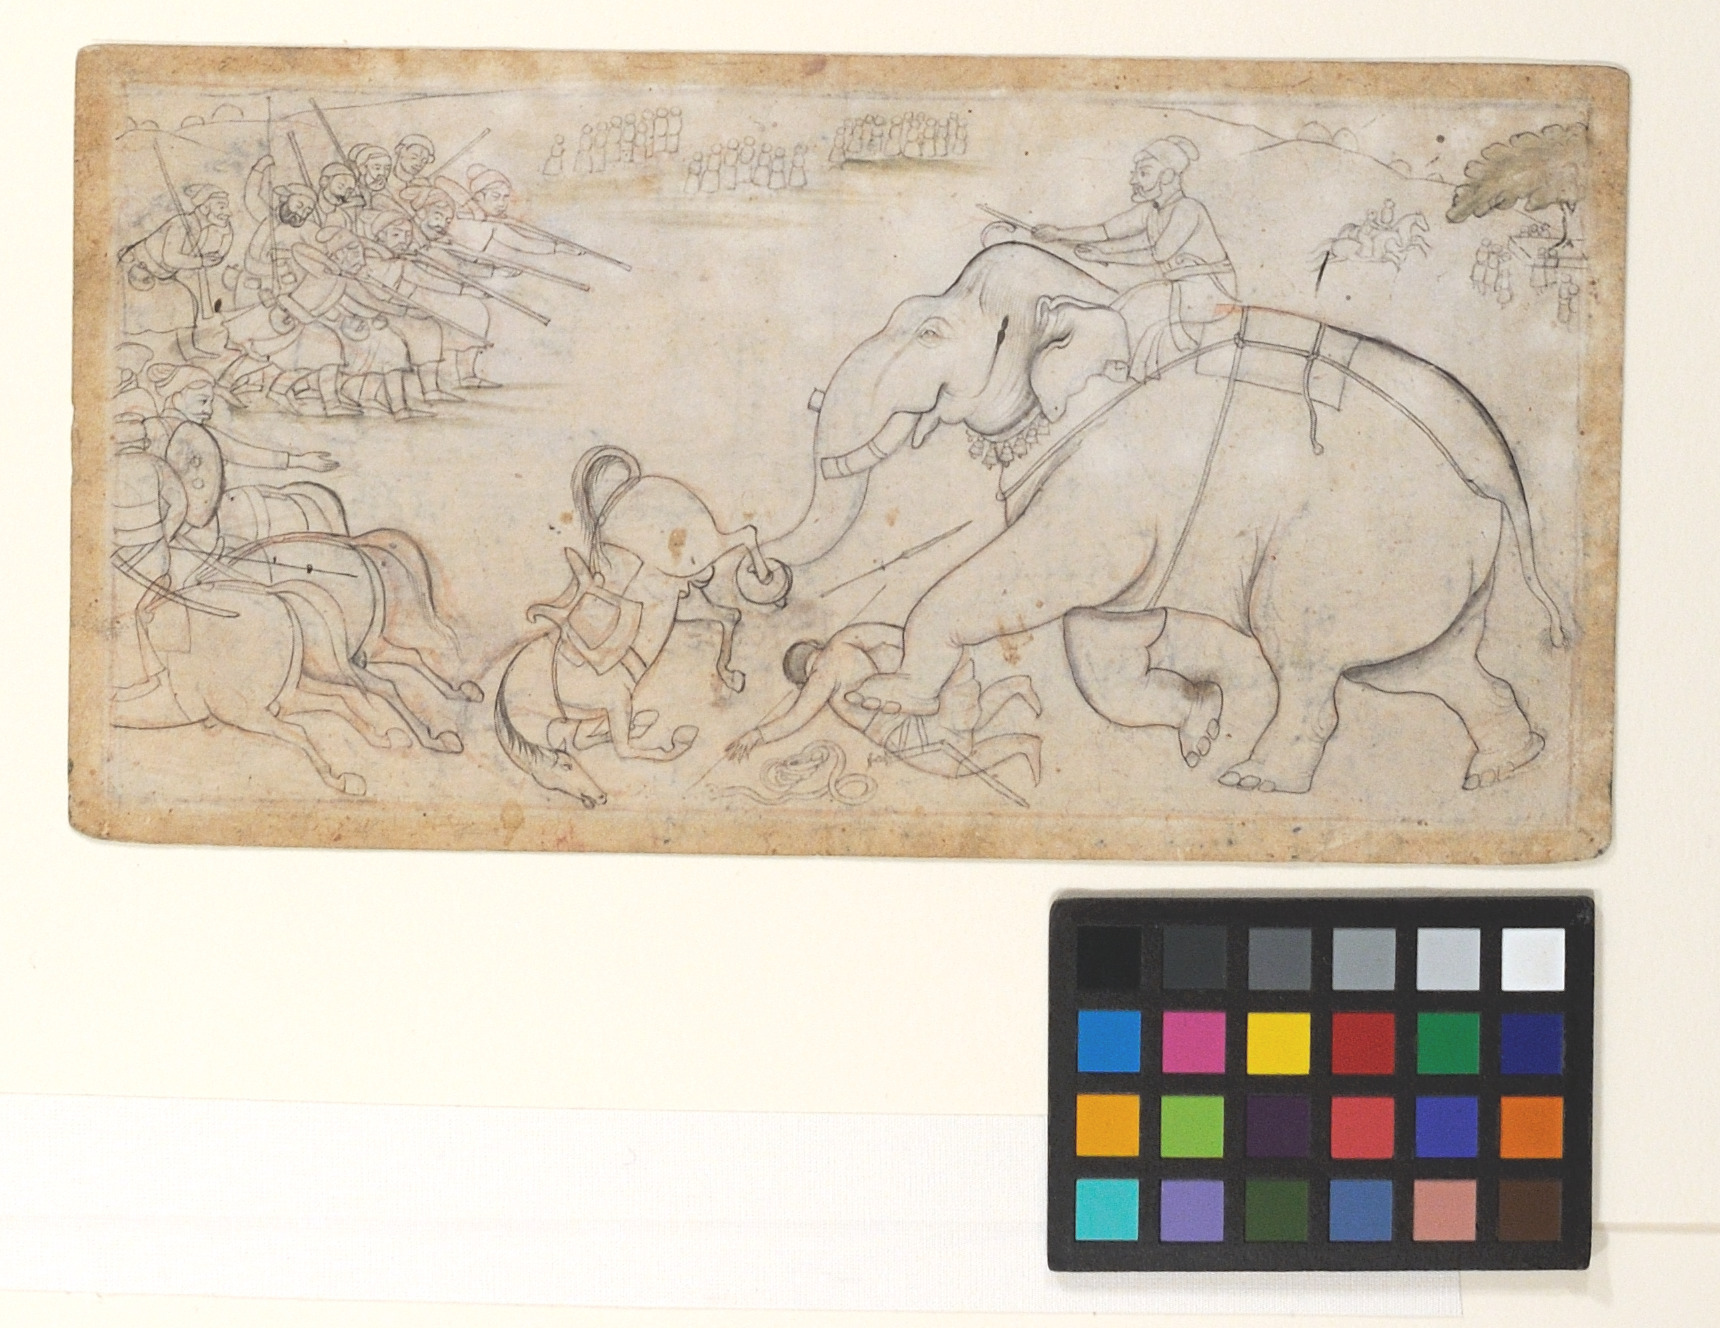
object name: drawing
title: Skirmish with an Elephant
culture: indian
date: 1800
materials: ink, paper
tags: battles,soldiers,firearms,elephants,horses